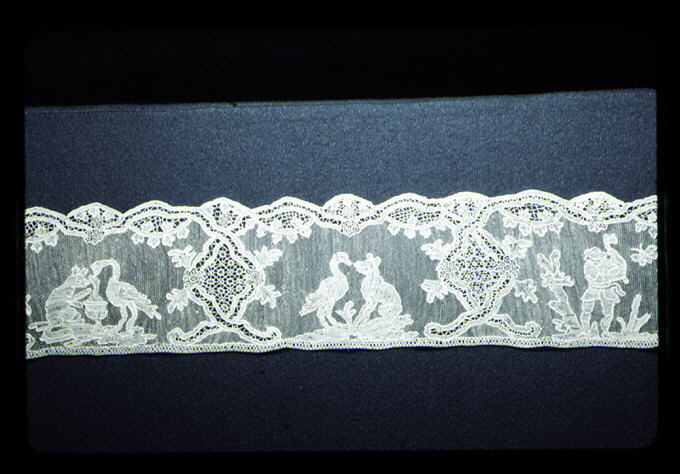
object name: piece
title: Piece (one of three)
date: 1701-1800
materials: lace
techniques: lace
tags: animals,birds